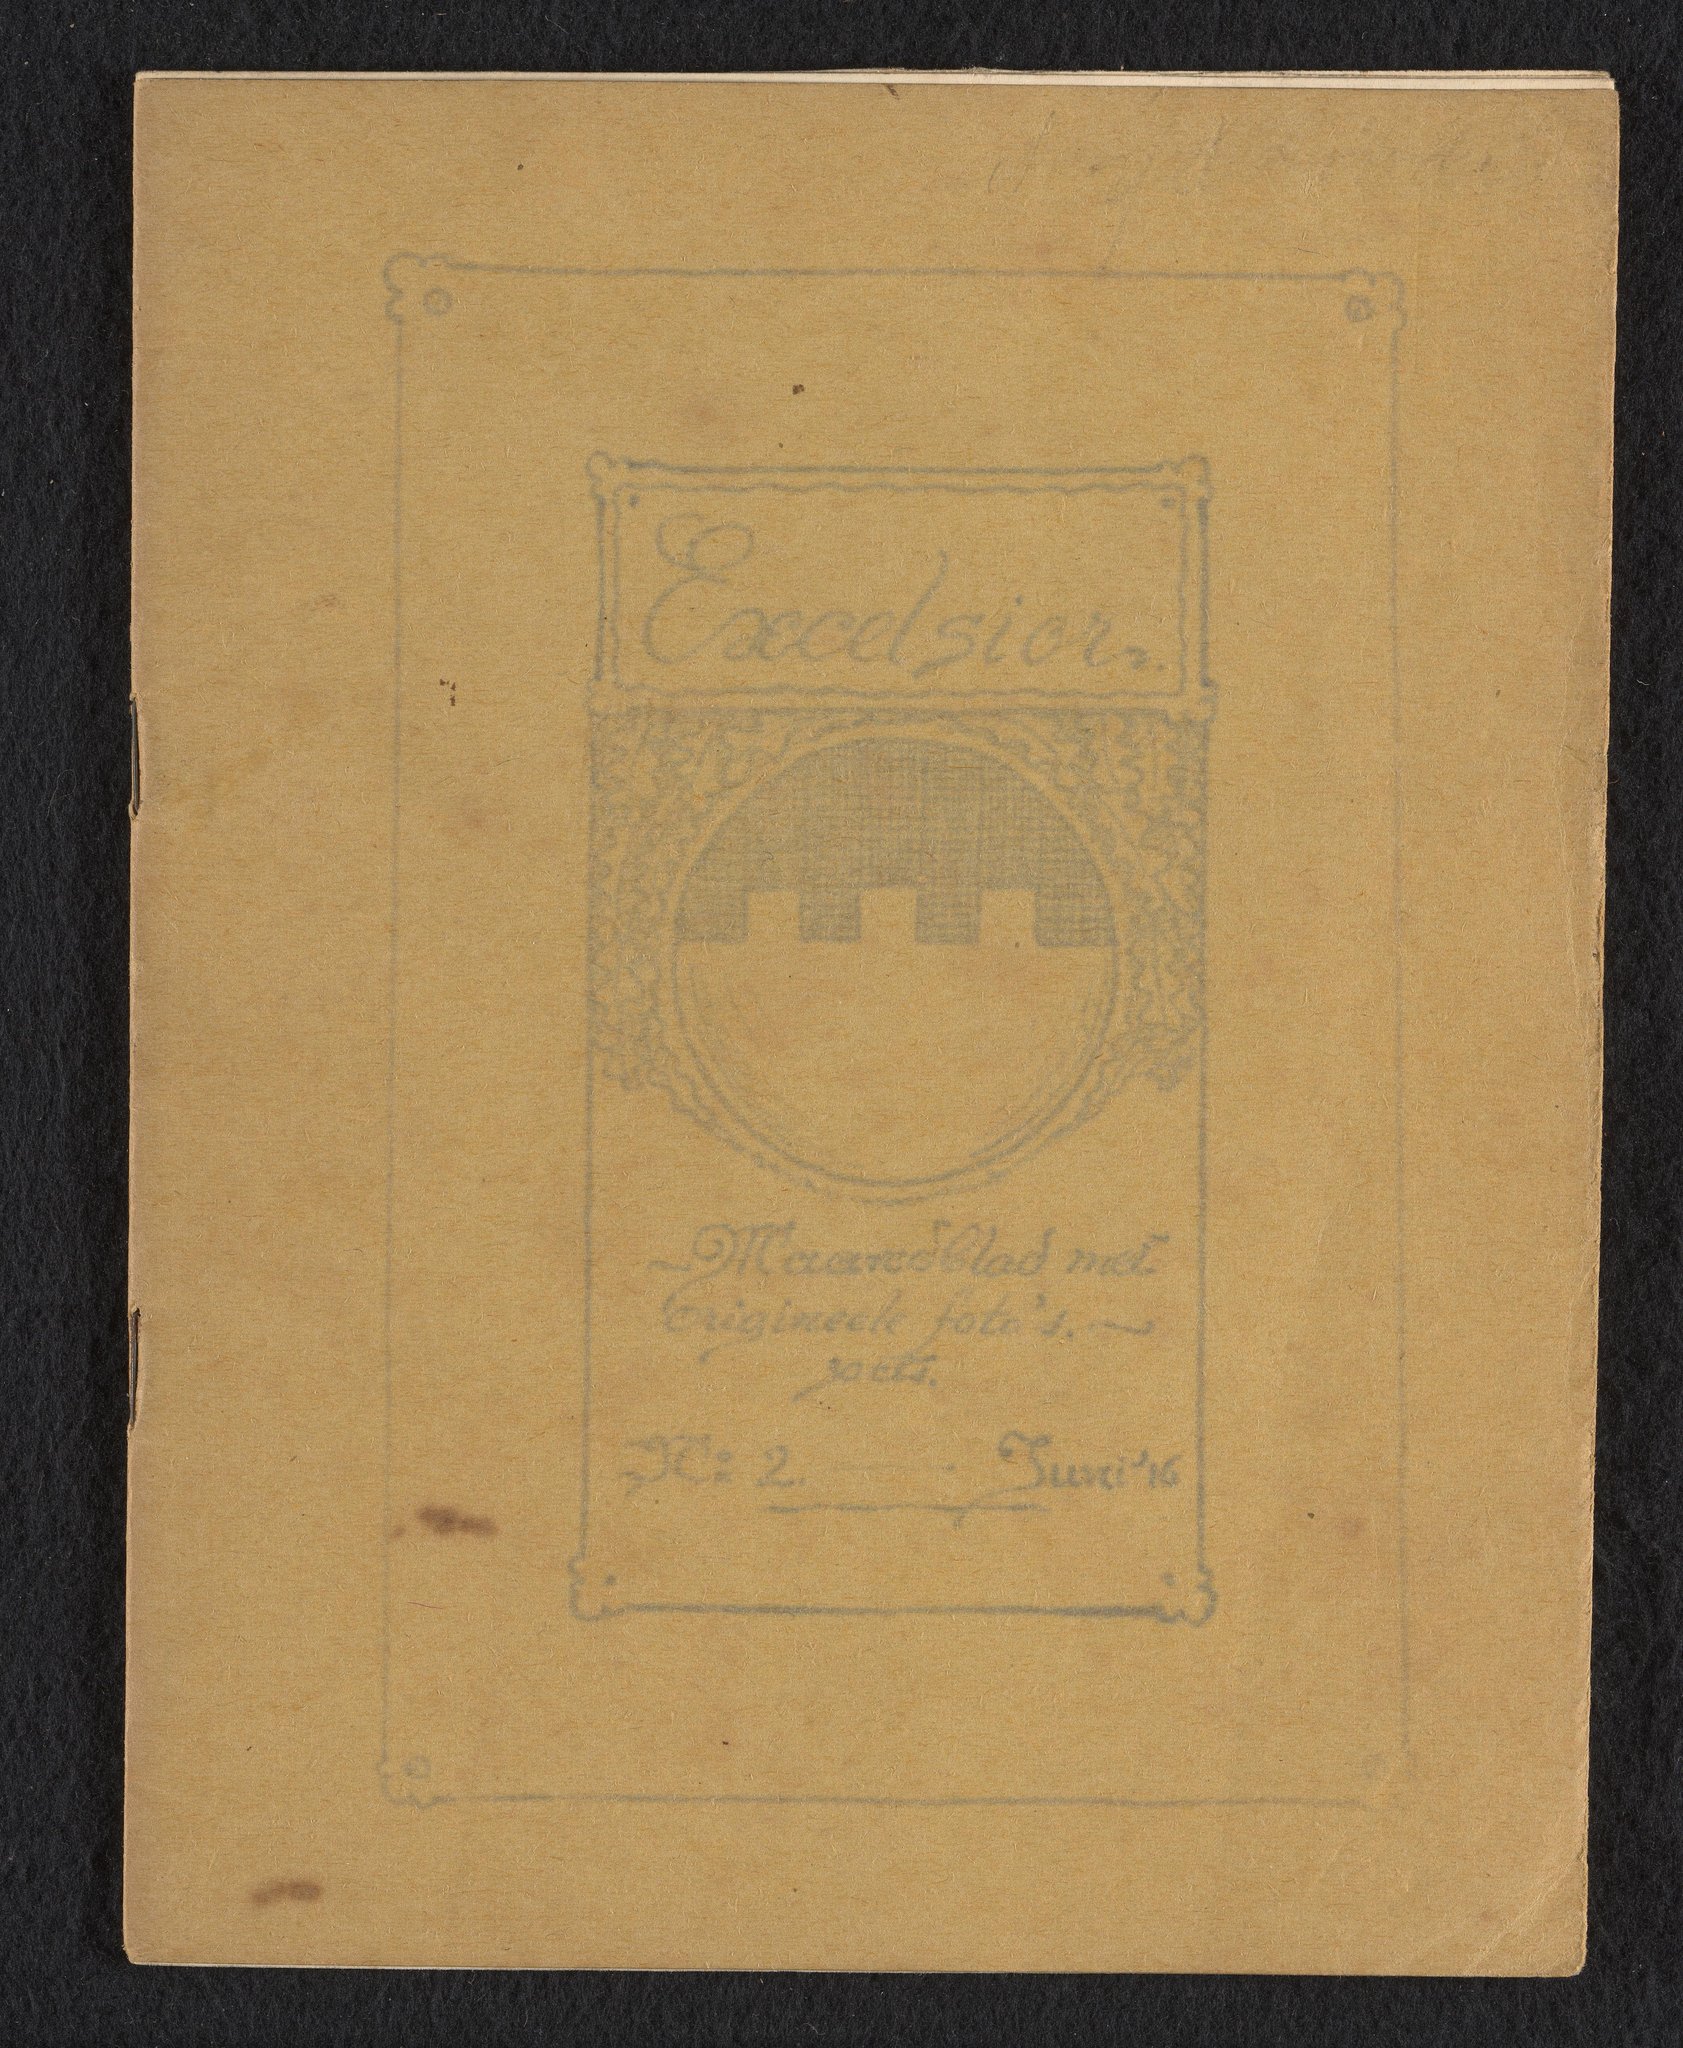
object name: magazine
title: Excelsior : een Nederlandsch maandblad met originele foto's geïllustreerd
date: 1906-1916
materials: ink, paper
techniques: hectograph, writing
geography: zeist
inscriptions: inscription: ‘30 cts./ N: 2.’